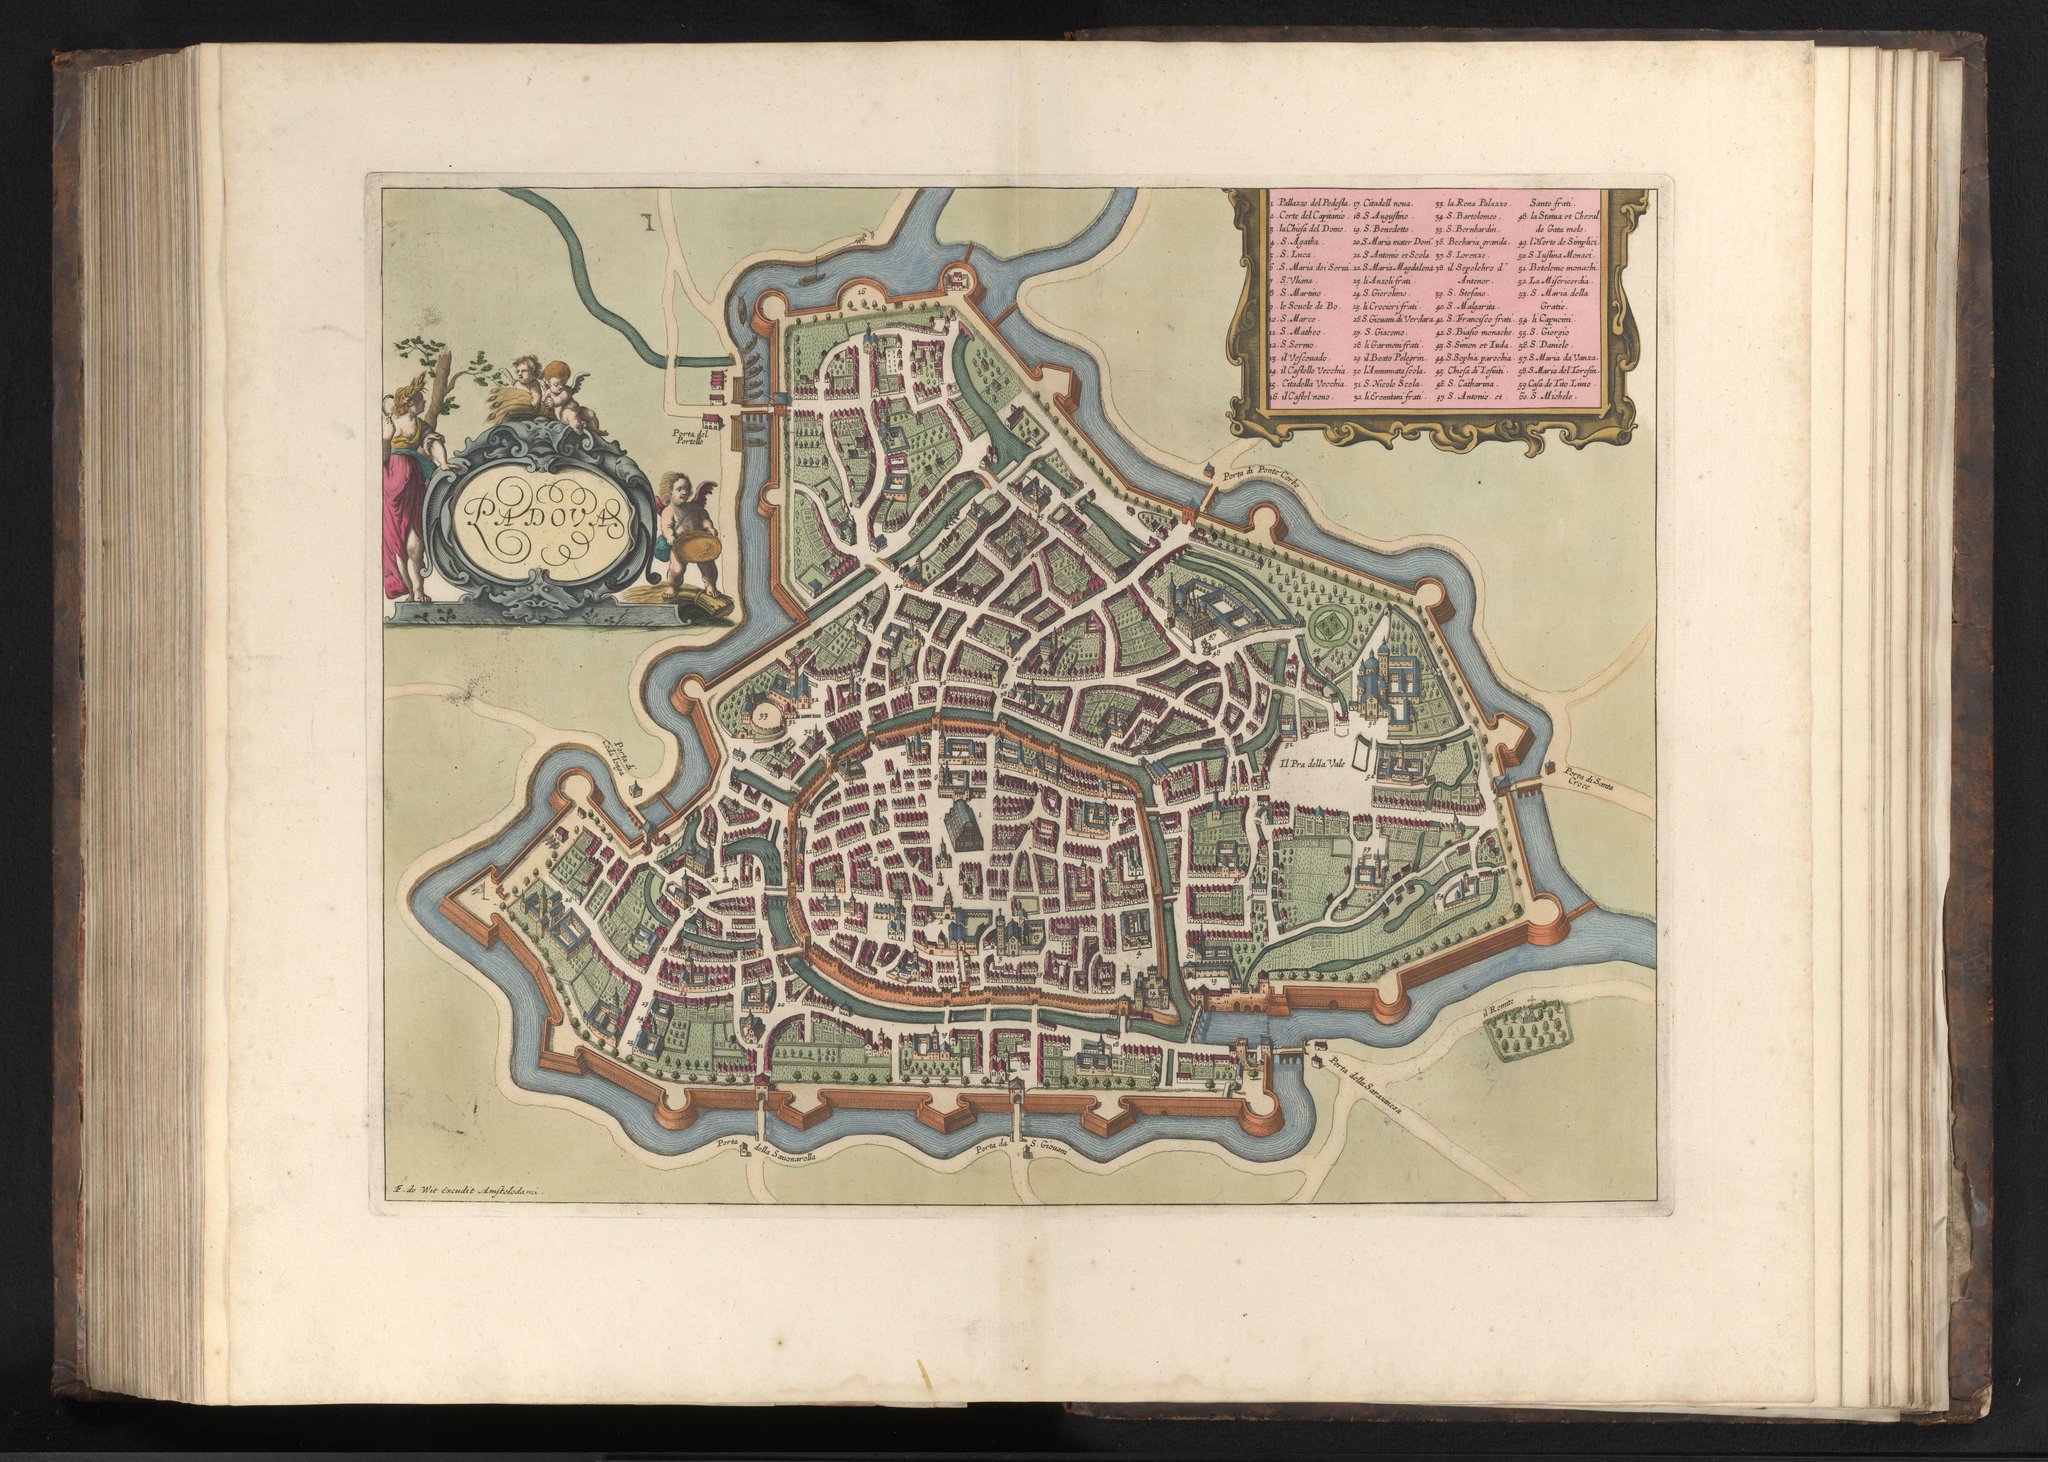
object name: album leaf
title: Padova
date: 1639-1706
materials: paper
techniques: colour, etching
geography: amsterdam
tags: bird's eye view ~ architectural design or model, maps of cities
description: Gezicht op Padua in vogelvluchtperspectief. Links een cartouche met titel. Rechtsboven een cartouche met een verklarende lijst met nummers. Prent maakt deel uit van een album.